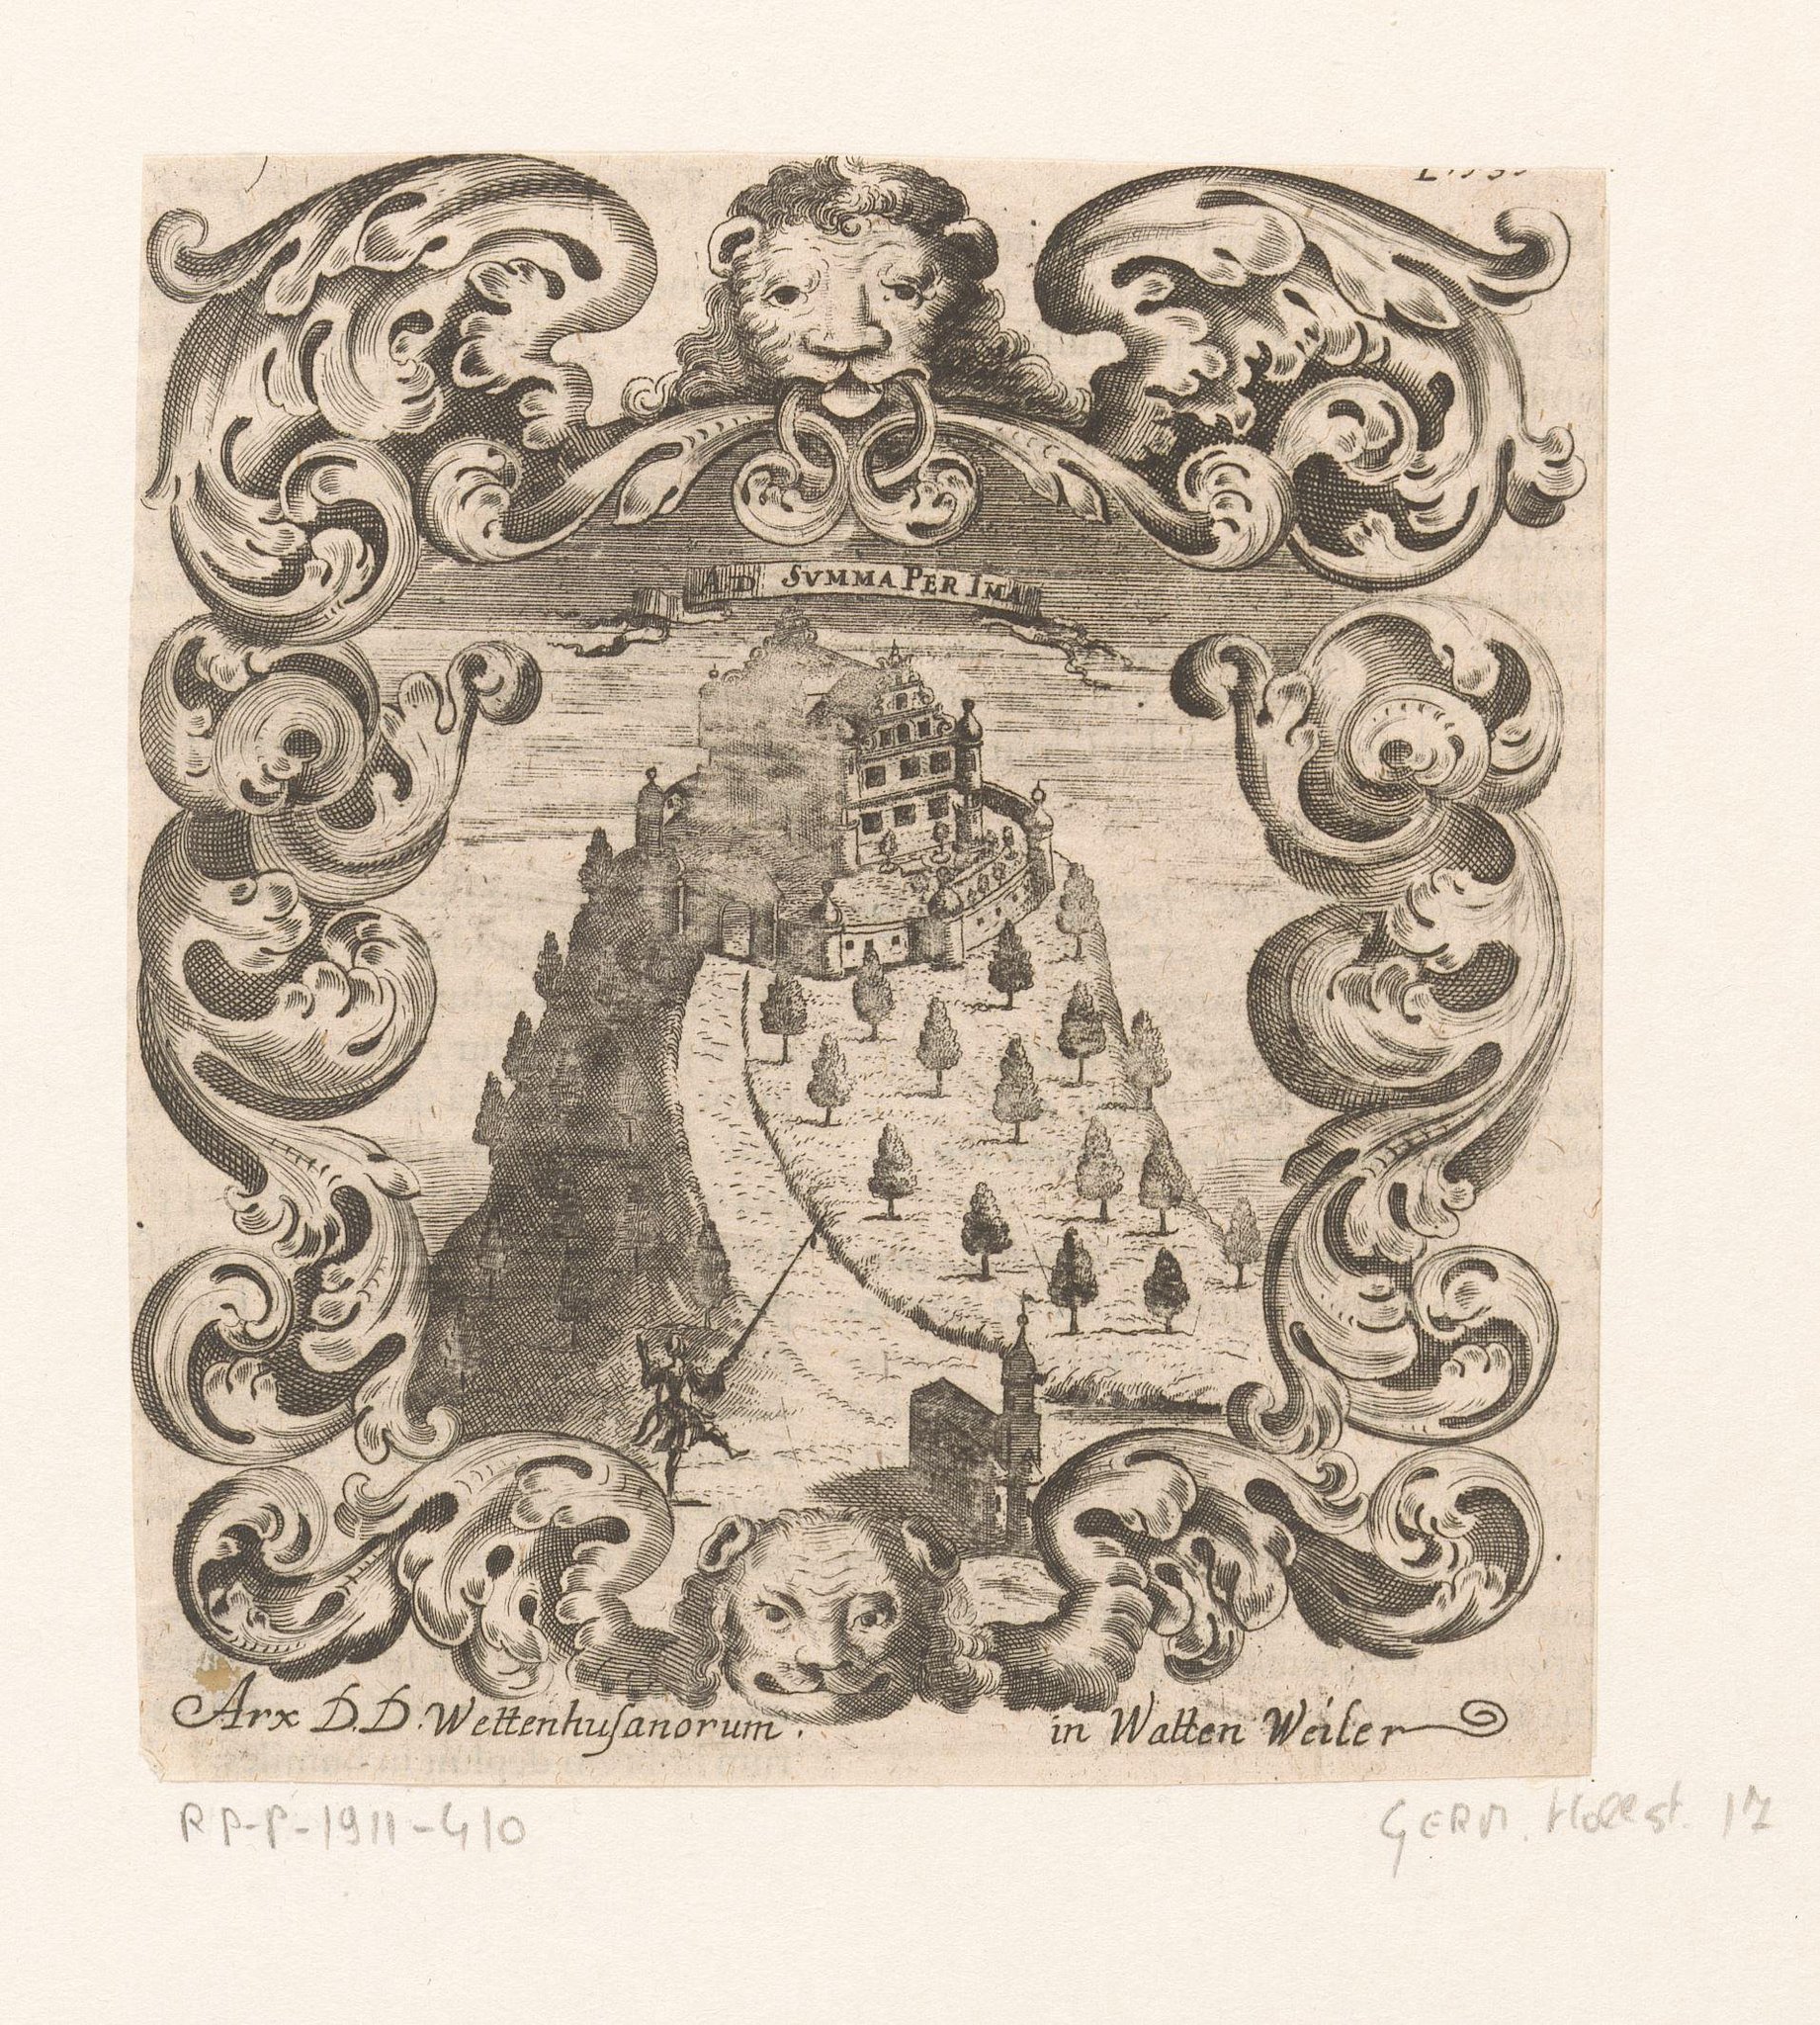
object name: book illustration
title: Kasteel op een berg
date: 1681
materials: paper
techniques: engraving, etching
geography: cologne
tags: castle, the soldier; the soldier's life, abstract ideas and concepts (+ emblematical representation of concept), mountains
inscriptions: collector's mark: Lugt 2228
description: Prent afkomstig uit: Erath, Augustin. Mundus symbolicus. Keulen: Thomae et Henrici Theodori von Cöllen, 1715.